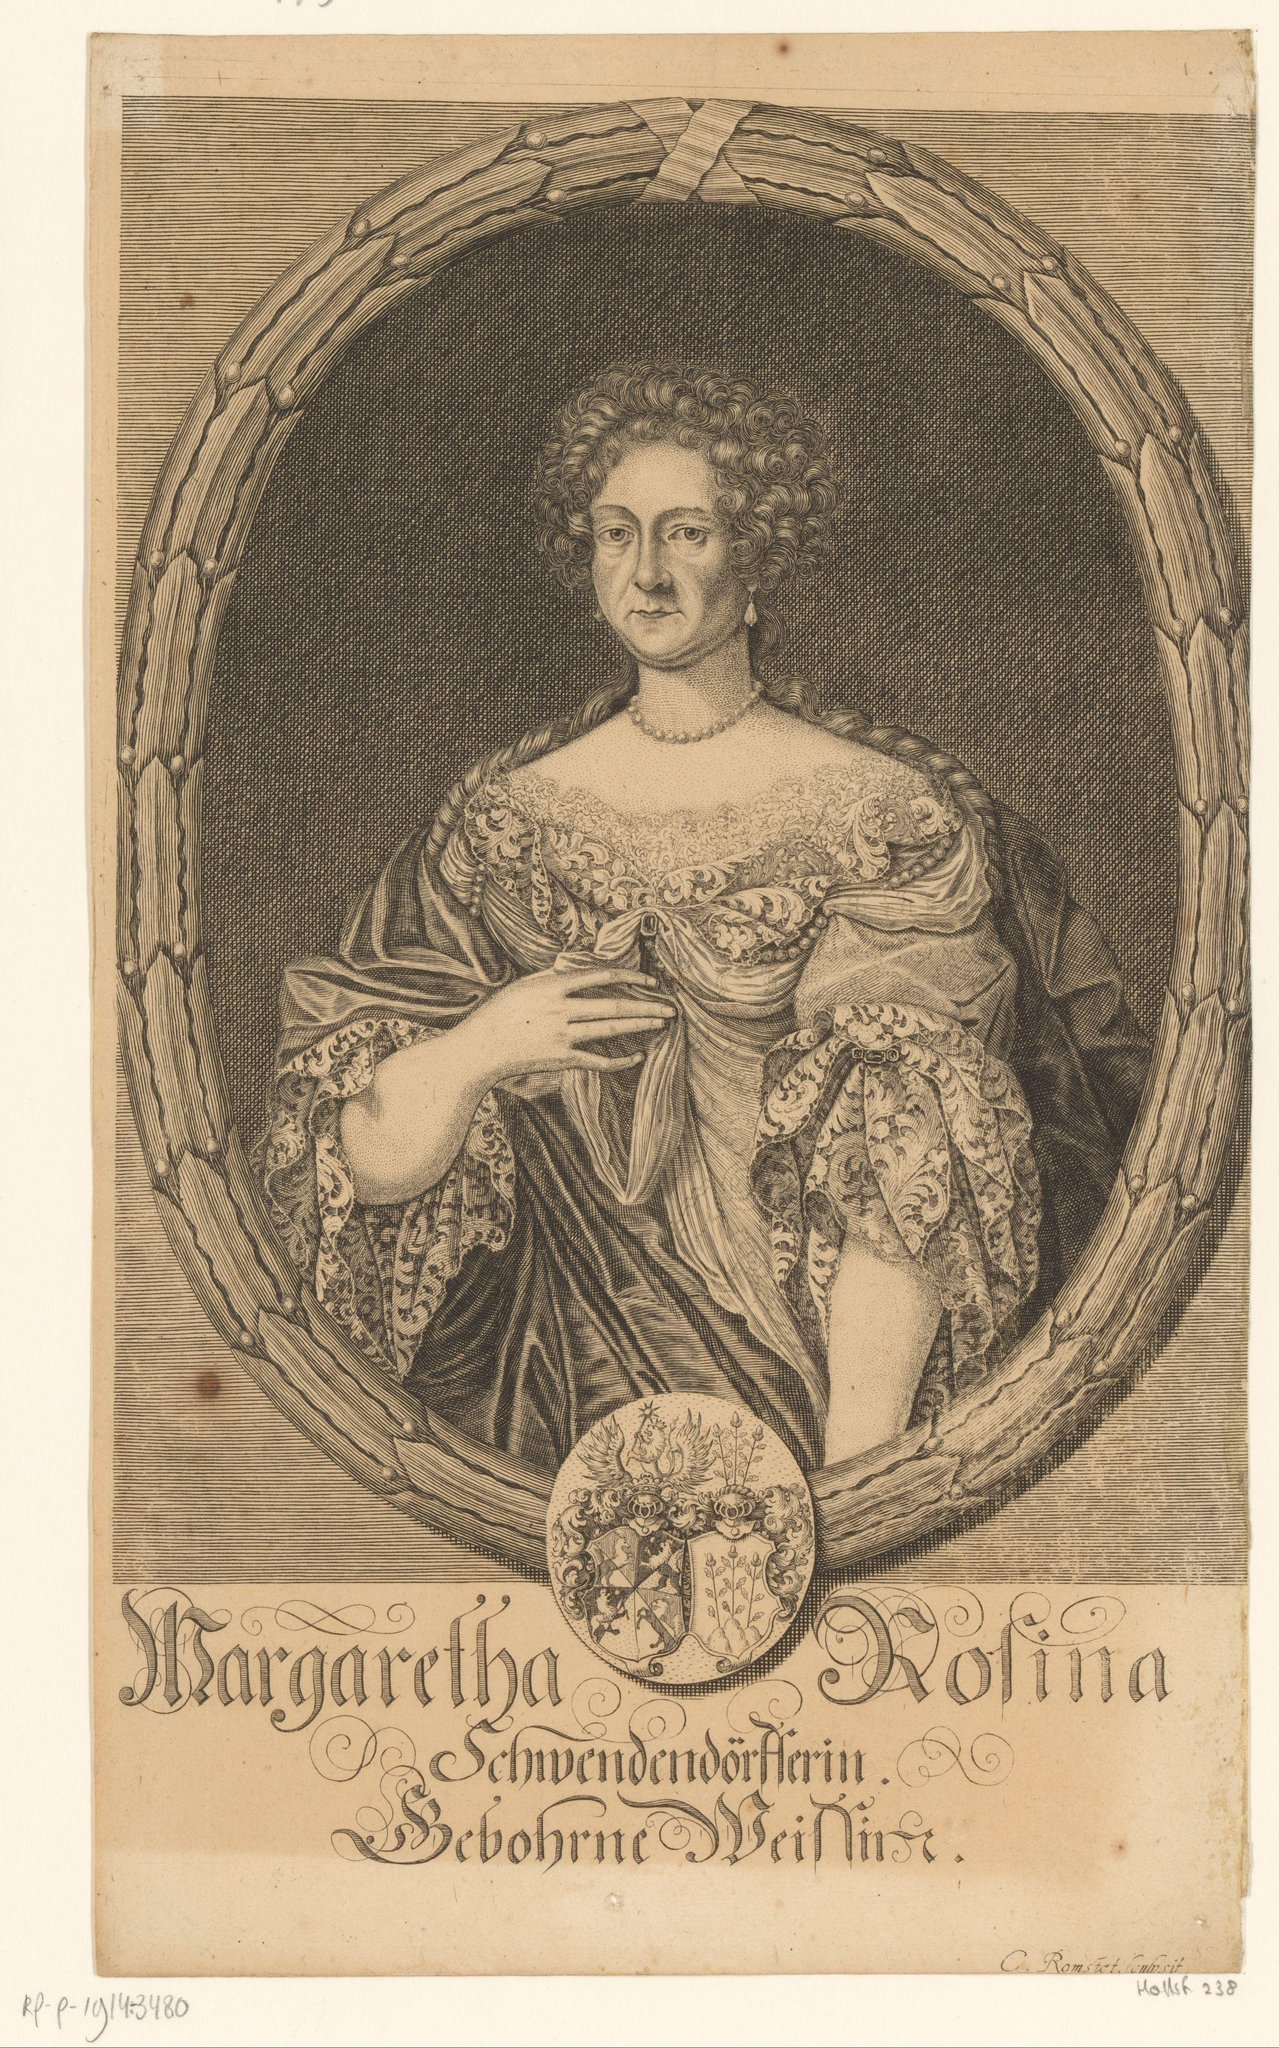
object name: print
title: Portret van Margaretha Rosina Schwendendörfer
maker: christian romstet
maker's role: print maker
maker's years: 1640-1721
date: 1665-1721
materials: paper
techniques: engraving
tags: historical persons - bb - woman, armorial bearing, heraldry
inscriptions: collector's mark: Lugt 2228